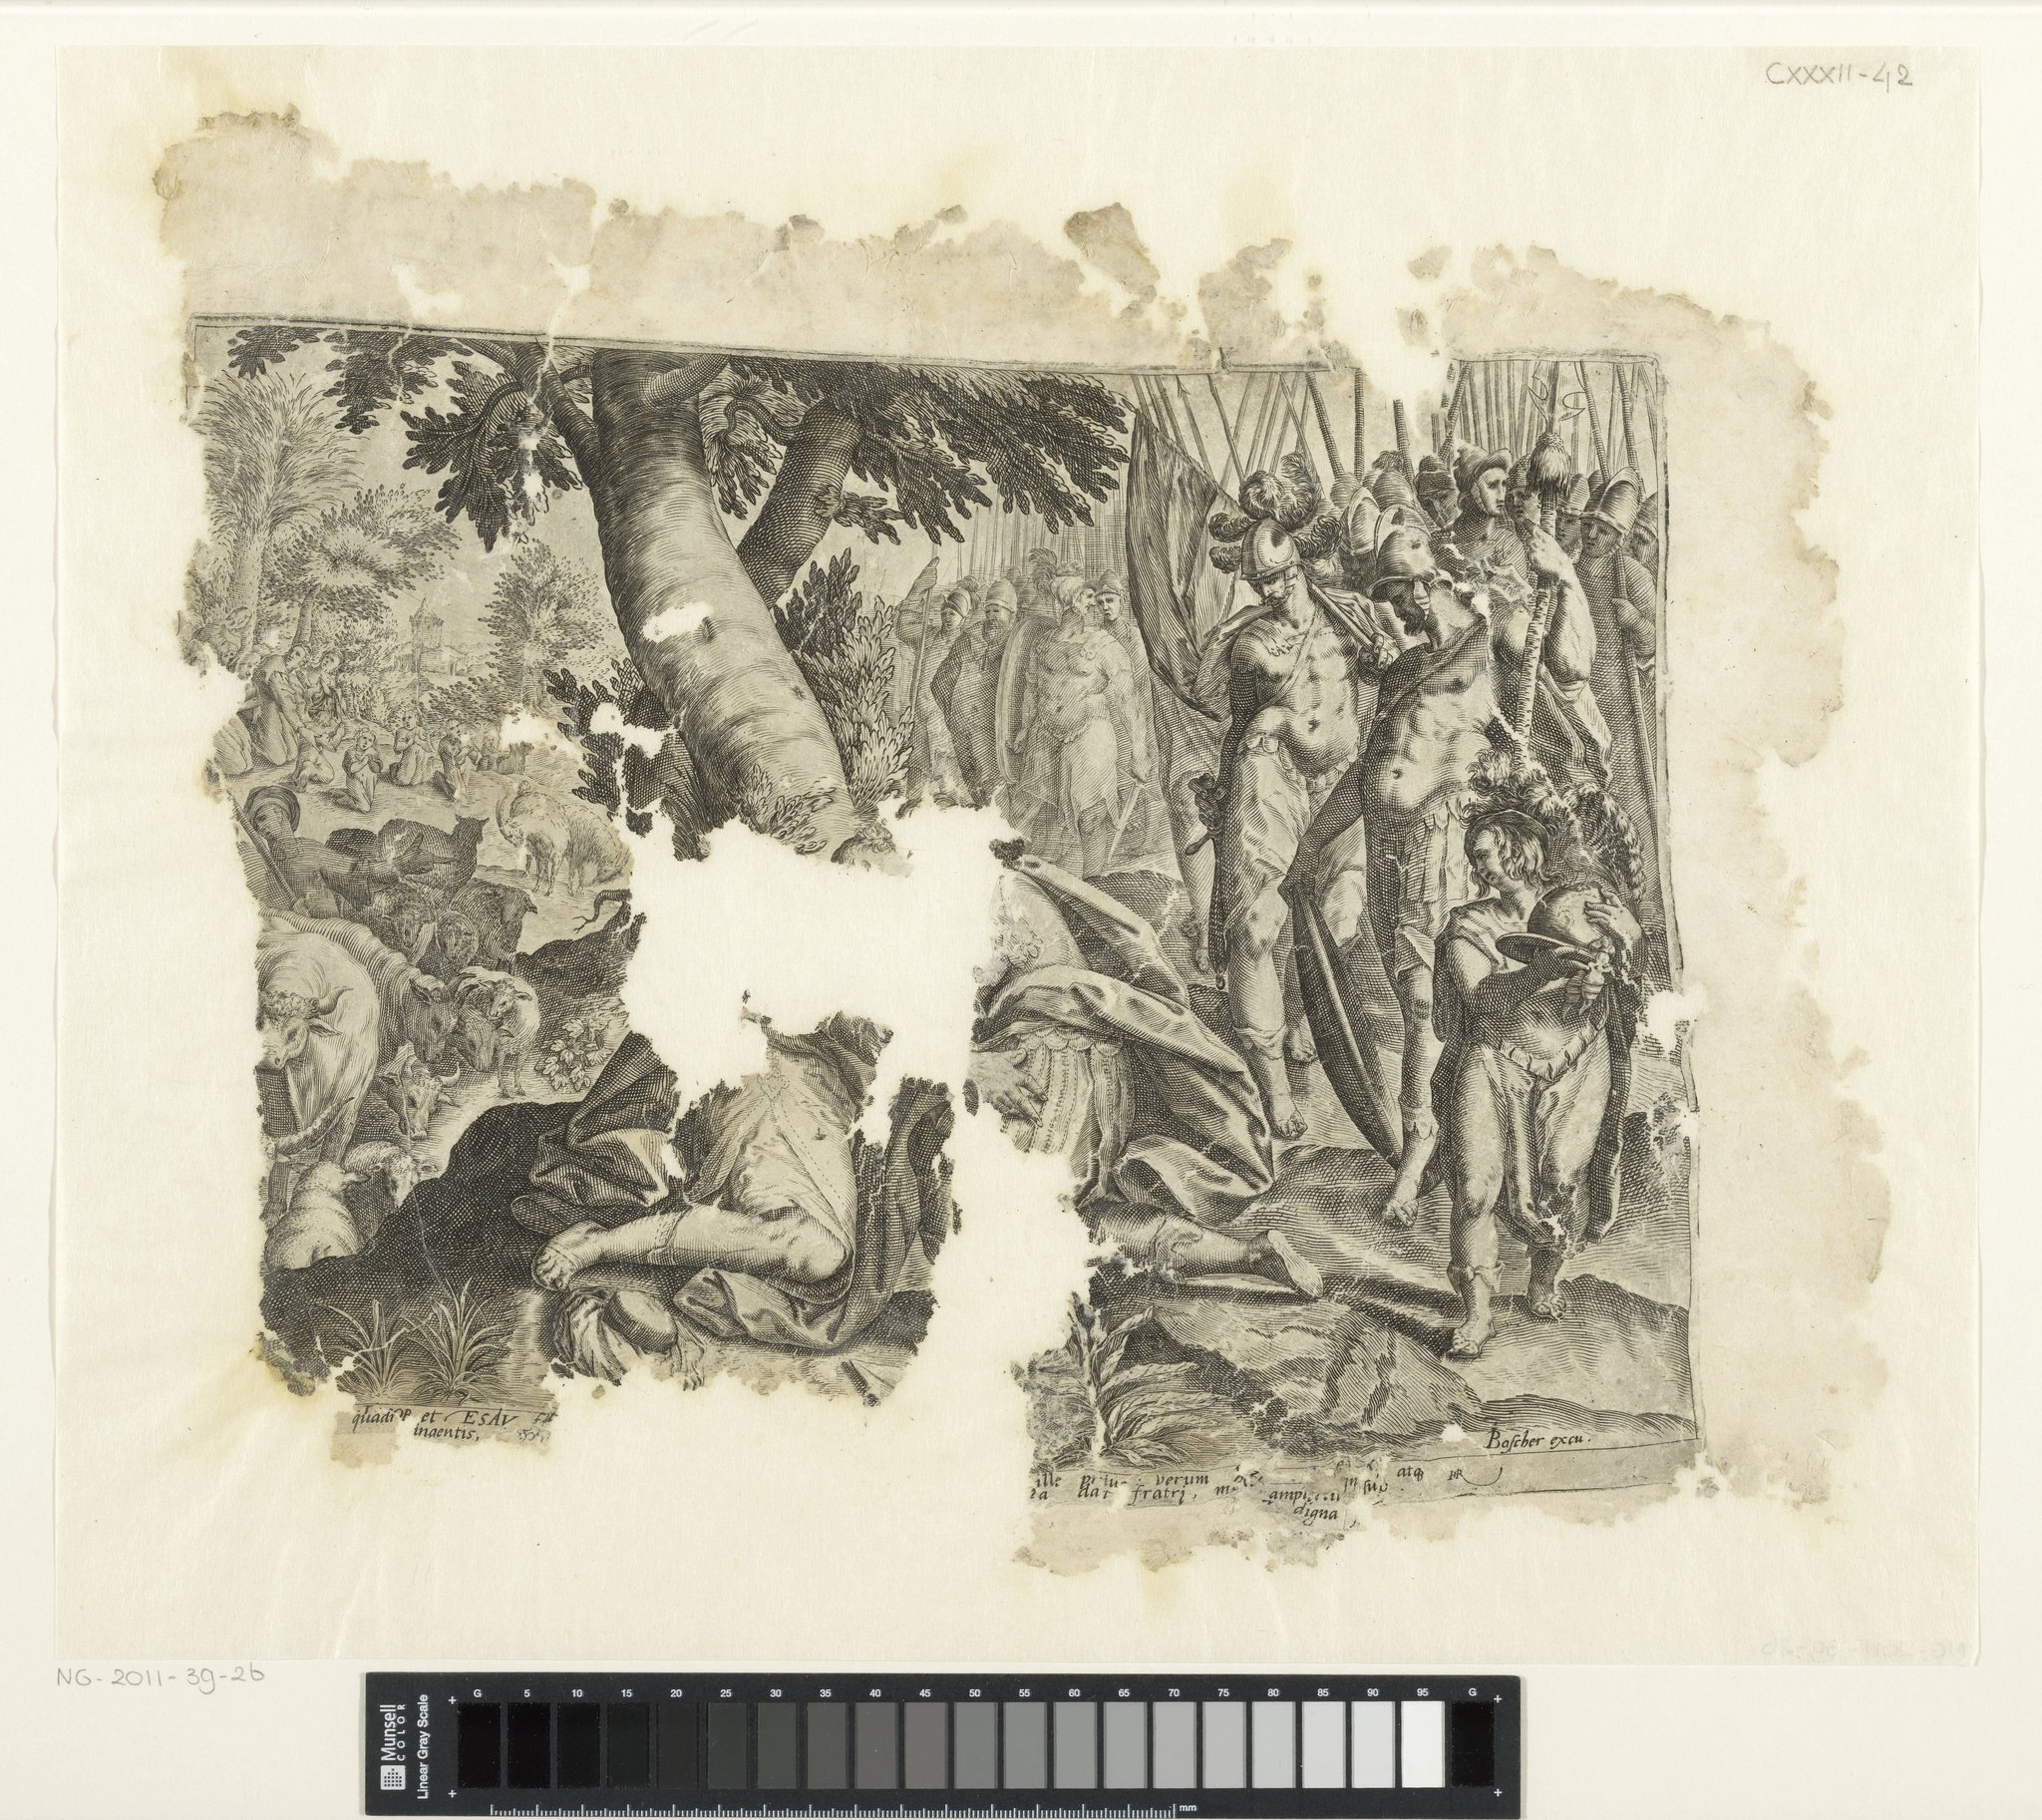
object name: print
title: Verzoening van Jakob en Esau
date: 1580-1596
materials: paper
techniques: engraving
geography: northern netherlands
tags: the meeting between esau and jacob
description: Tot dusverre was deze prent alleen bekend in een latere editie met het adres van C.J. Visscher in het door hem uitgegeven Theatrum Biblicum uit 1643, zie RP-P-1976-30-39. De prenten in de Nova Zembla collectie zijn tijdens een expeditie van Willem Barendsz en Jacob van Heemskerk in 1596-1597 noodgedwongen in het winterkamp, het ‘Behouden Huis’, op het eiland achtergelaten. De prenten waren in één of meerdere stapels als handelswaar meegenomen vanuit Amsterdam. Bijna drie eeuwen later, in 1871, keerde de Noor Elling Carlsen terug naar Nova Zembla en vond daar de restanten van het ‘Behouden Huis, inclusief een groot deel van de inventaris. Een deel van de prenten, in de vorm van aaneengekoekte kluiten, werd toen ook teruggevonden. De papierkluiten waren soms op meerdere plekken gebroken. Tussen 1975-1979 zijn de prenten van elkaar gescheiden. Dit leverde in totaal ca. 1000 fragmenten van ca. 400 afdrukken van ca. 150 verschillende prenten op. Voor zover mogelijk zijn de fragmenten samengevoegd en zijn de prenten gereconstrueerd.